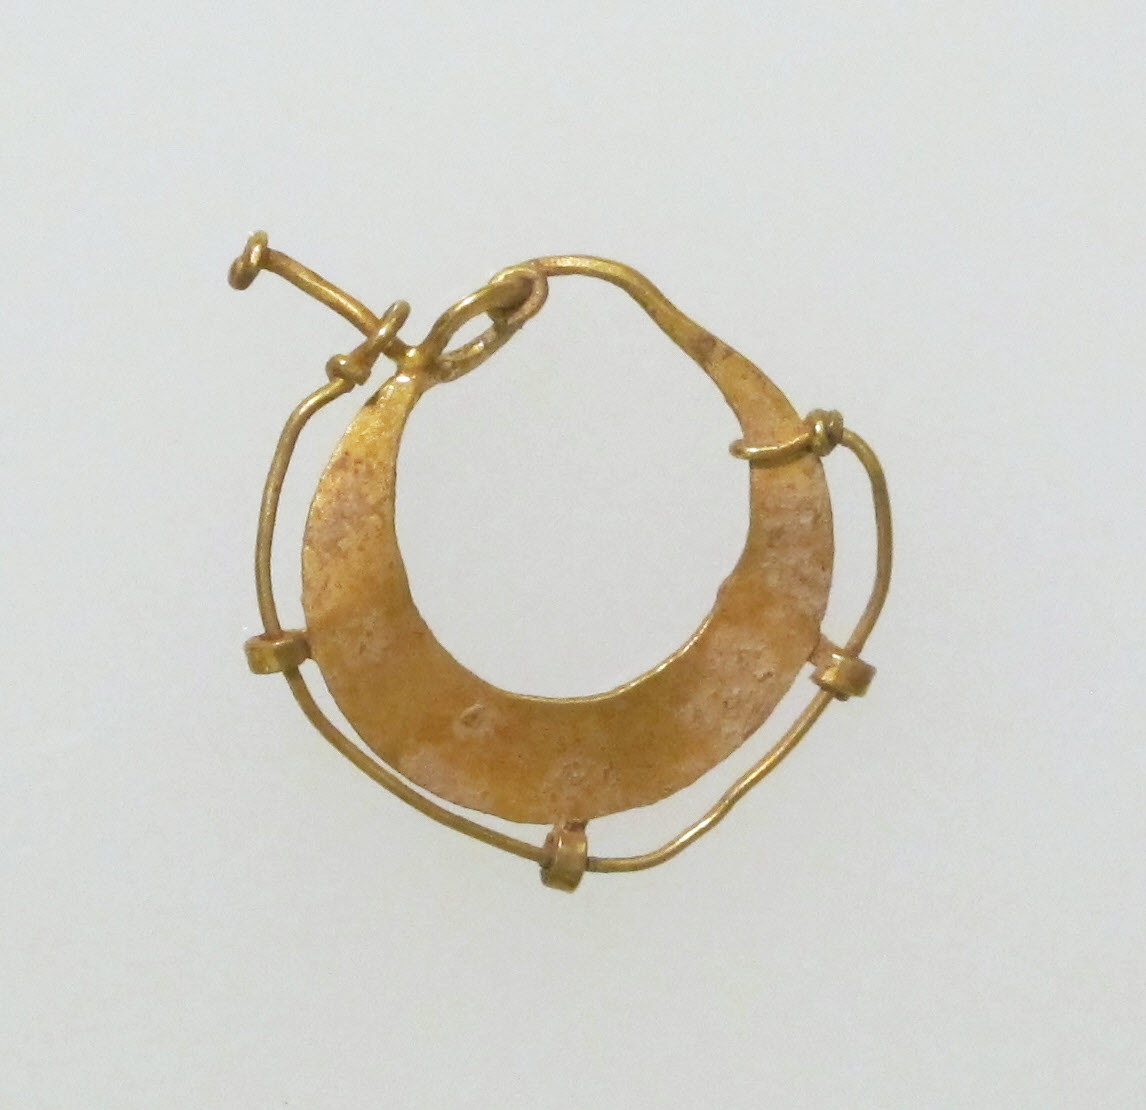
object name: earring, crescent shaped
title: Earring, crescent-shaped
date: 7000 BCE-330 CE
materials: gold